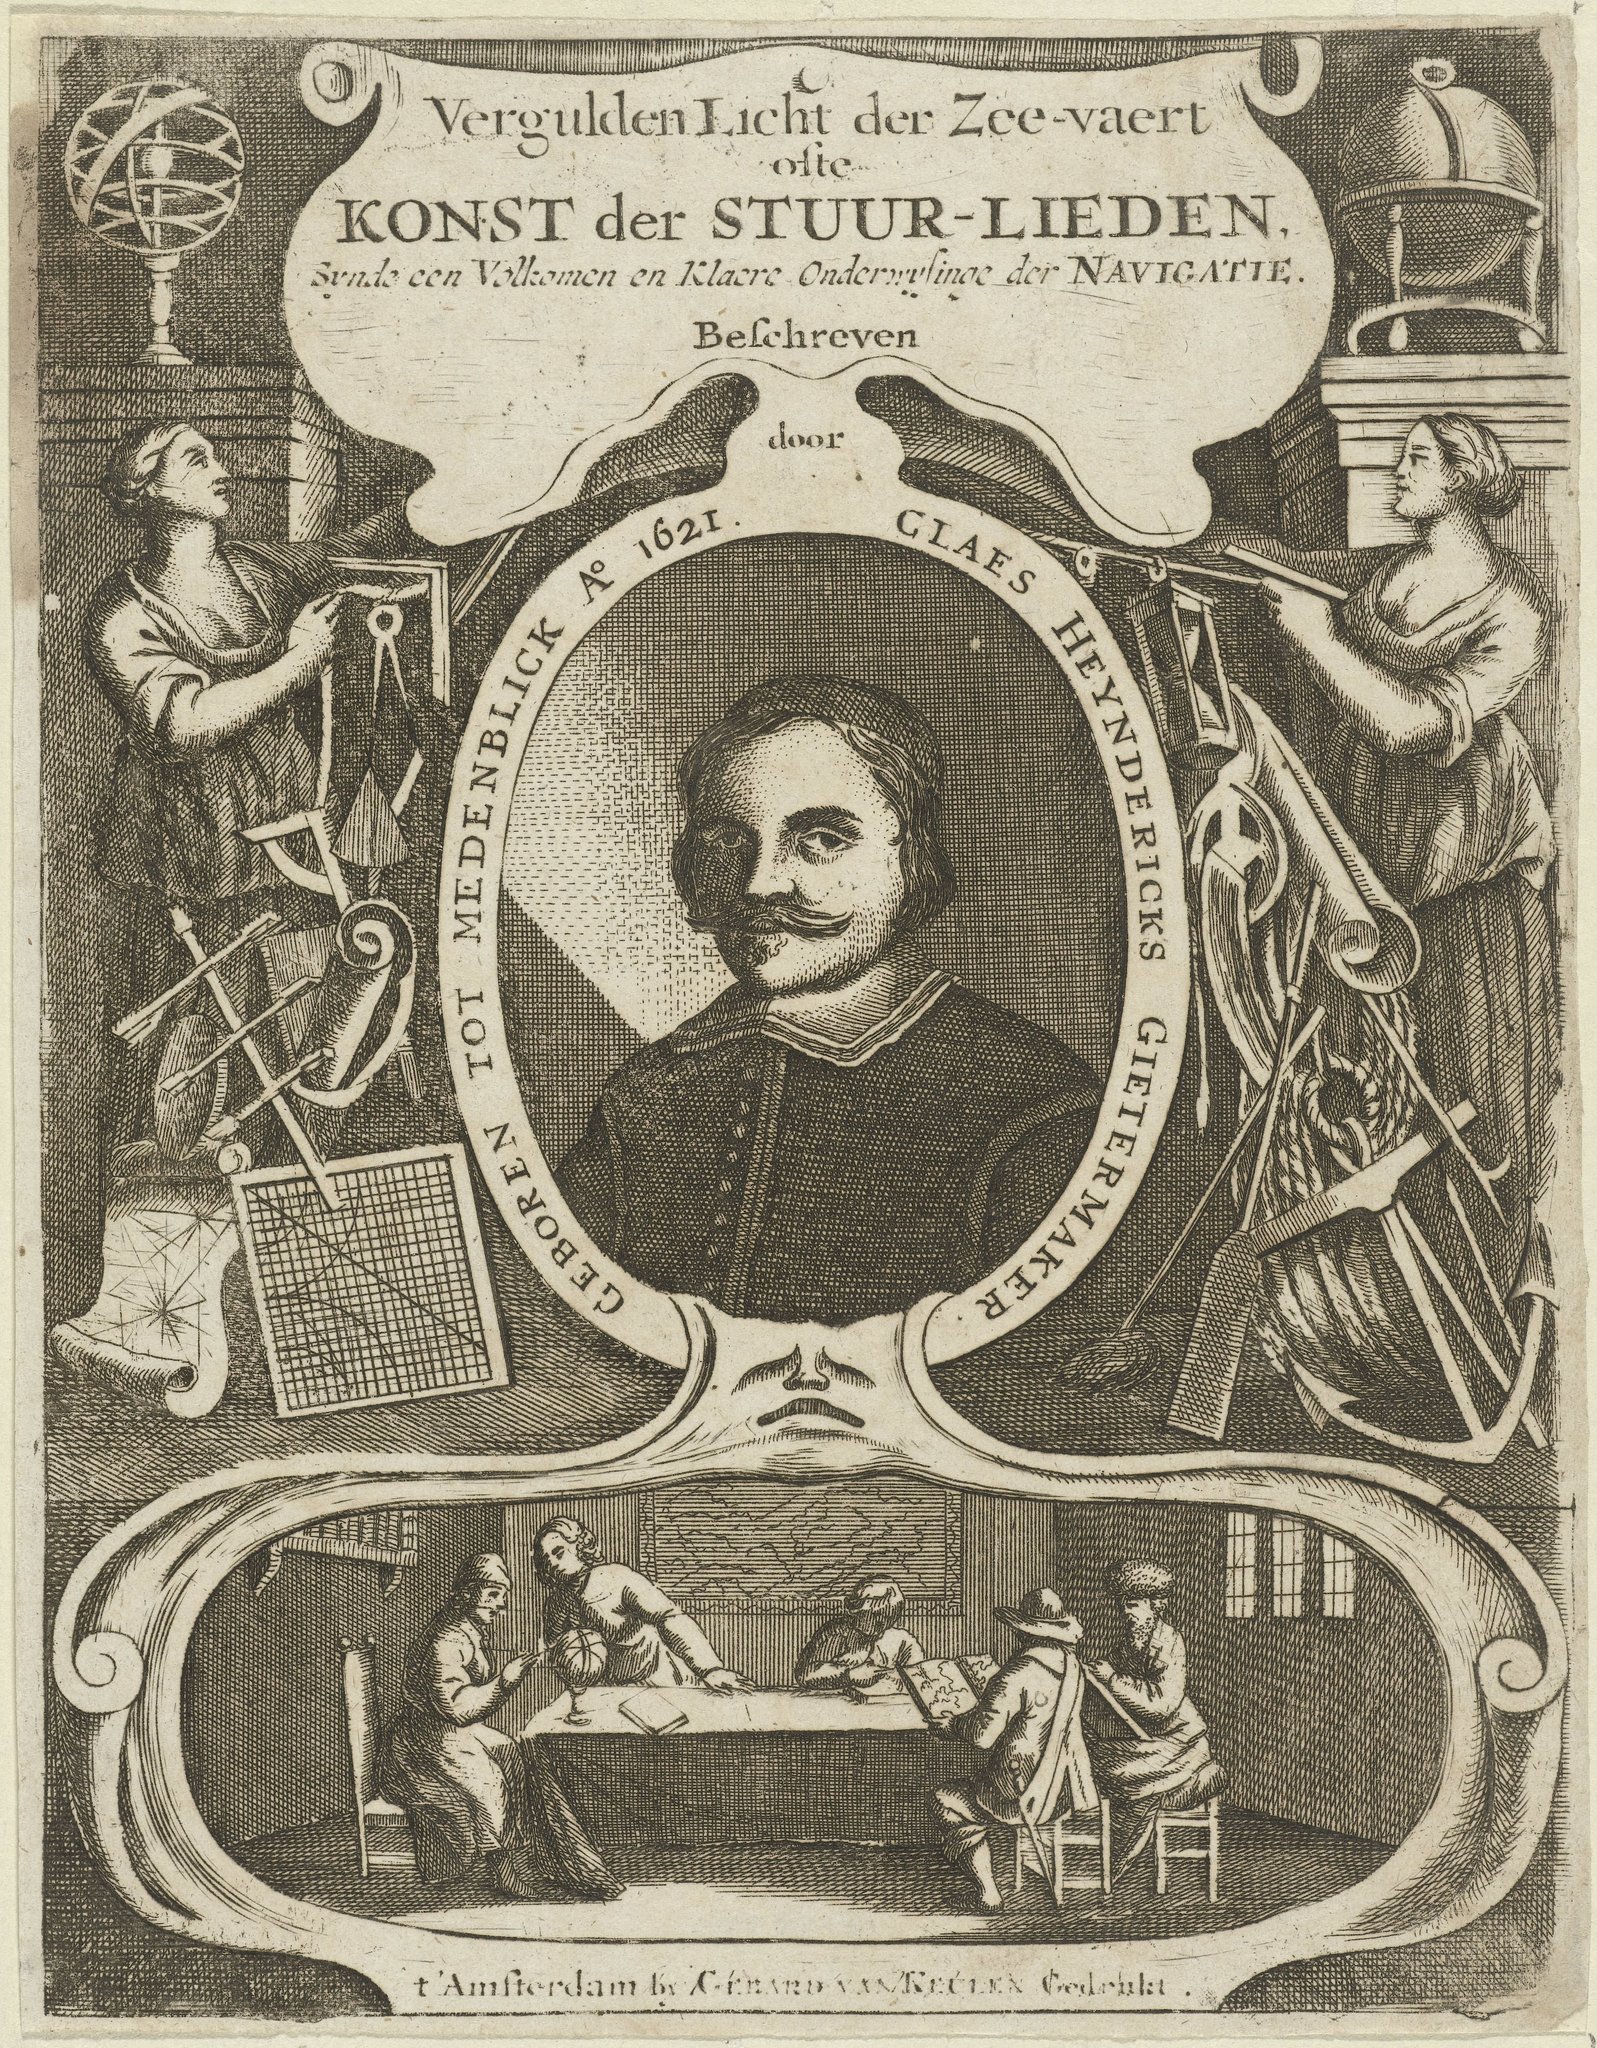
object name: print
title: Titelpagina voor: C.H. Gietermaker, Konst der Stuur-lieden, 1697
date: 1697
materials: paper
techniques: etching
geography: amsterdam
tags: measuring-instruments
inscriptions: collector's mark: Lugt 2228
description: Buste naar links van Klaas Hendriksz Gietermaker in een ovaal met randschrift in het Nederlands. Links en rechts van het portret een vrouwfiguur met meet- en navigatie-instrumenten. Onderaan een cartouche met vijf figuren rond een tafel waarop een globe en boeken. Bovenaan de titel.